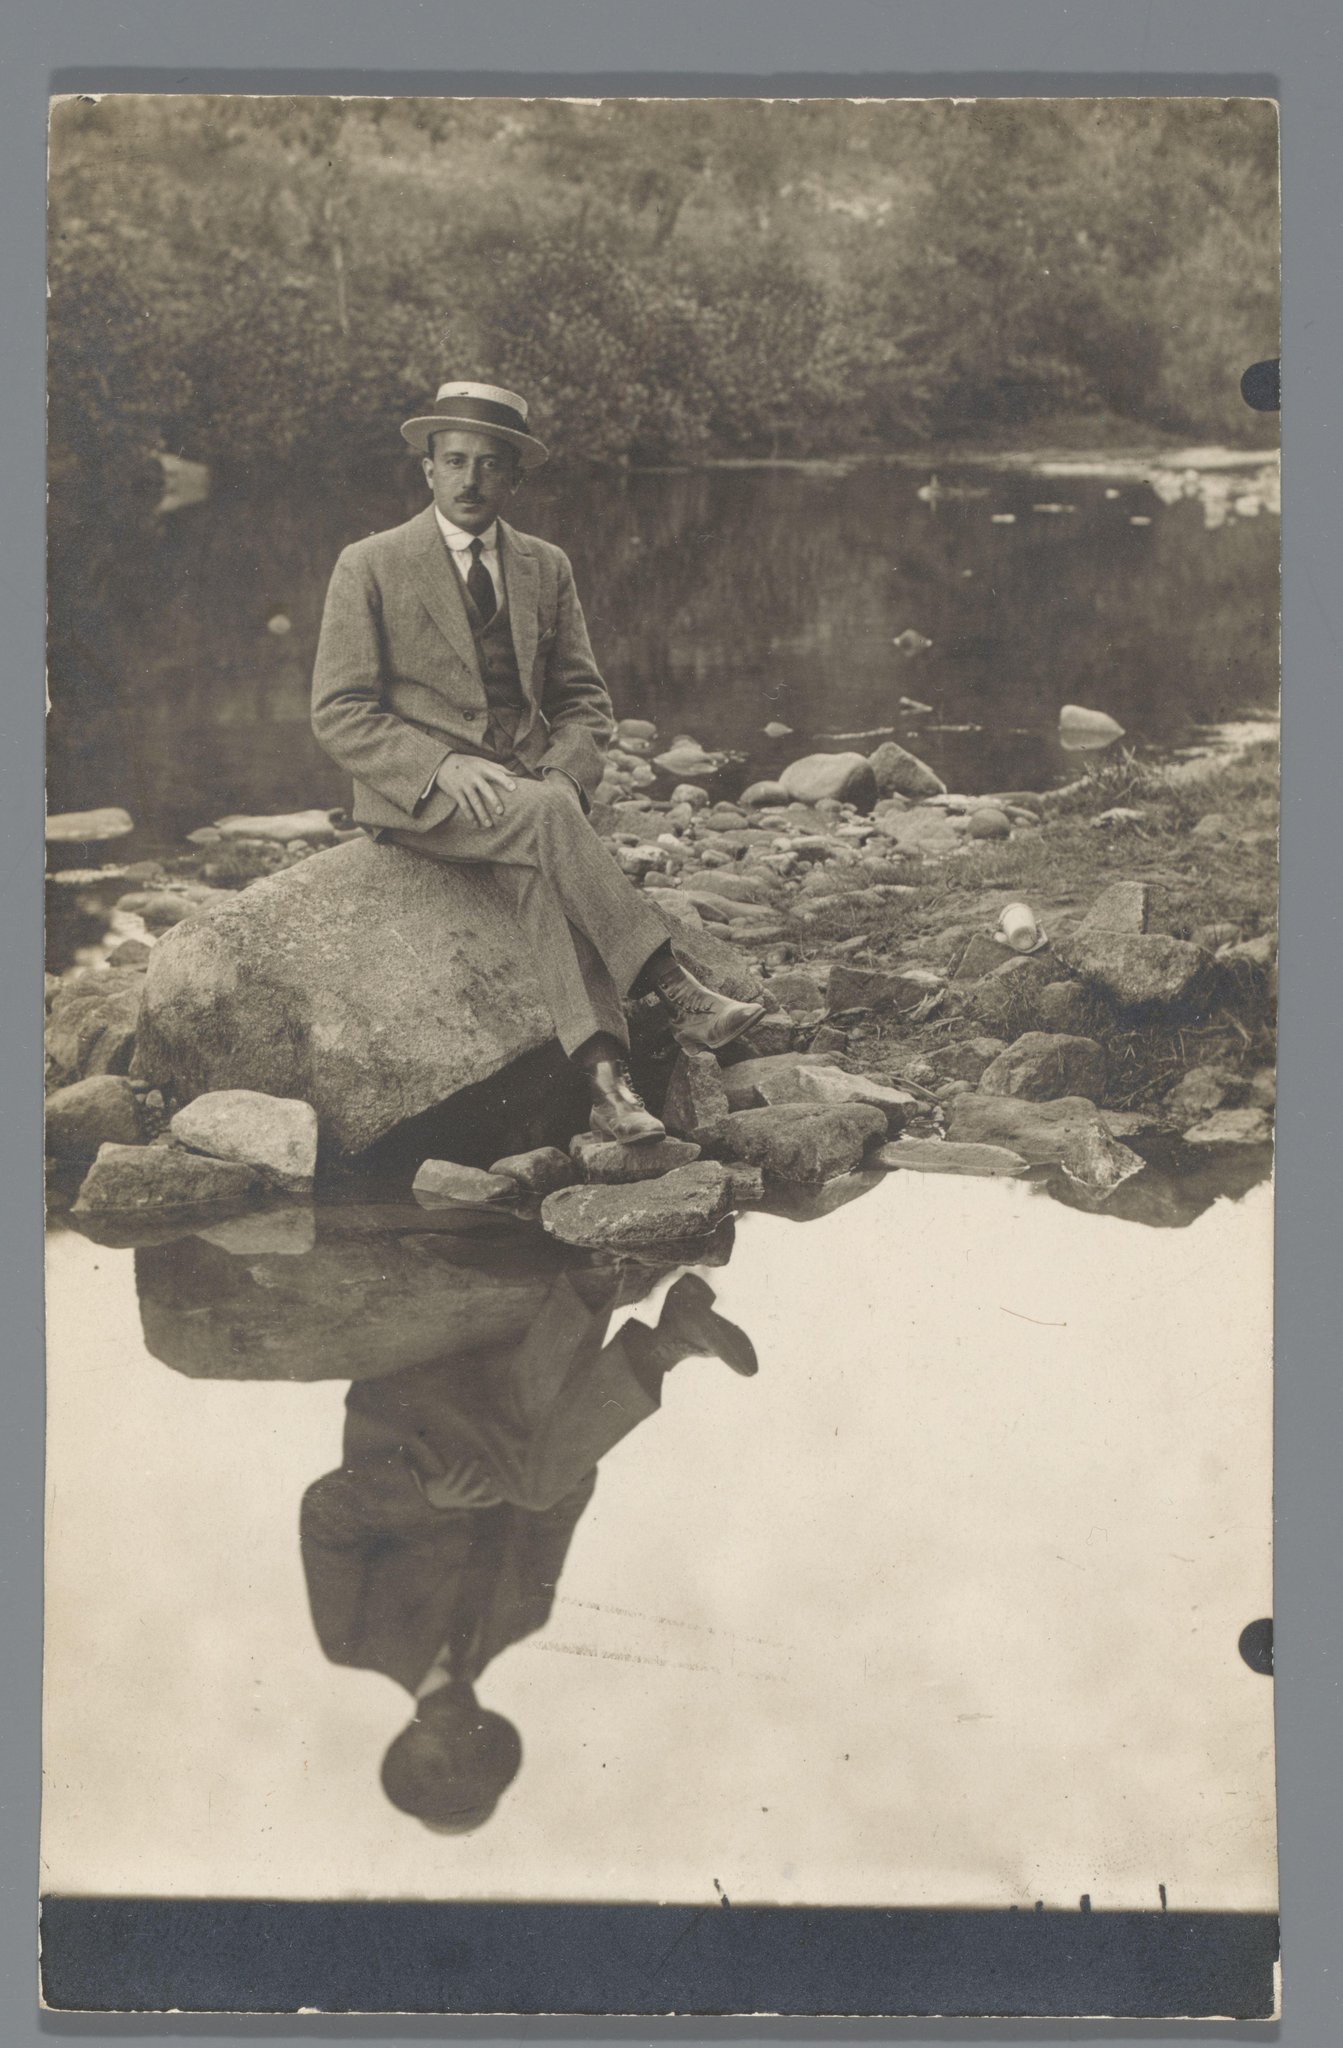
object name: ansichtkaart, prentbriefkaart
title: Portret van Benjamin Hernandez zittend op een steen in een rivier, het water reflecteert zijn spiegelbeeld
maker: arturo montero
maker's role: fotograaf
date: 1922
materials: cardboard, photographic support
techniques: gelatin silver print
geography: spain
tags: adult man, river (+ landscape with figures, staffage), reflection (in a mirror)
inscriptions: name: ‘Benjamin Hernandez/ abril 3/922/ 10-6/ Mexico’